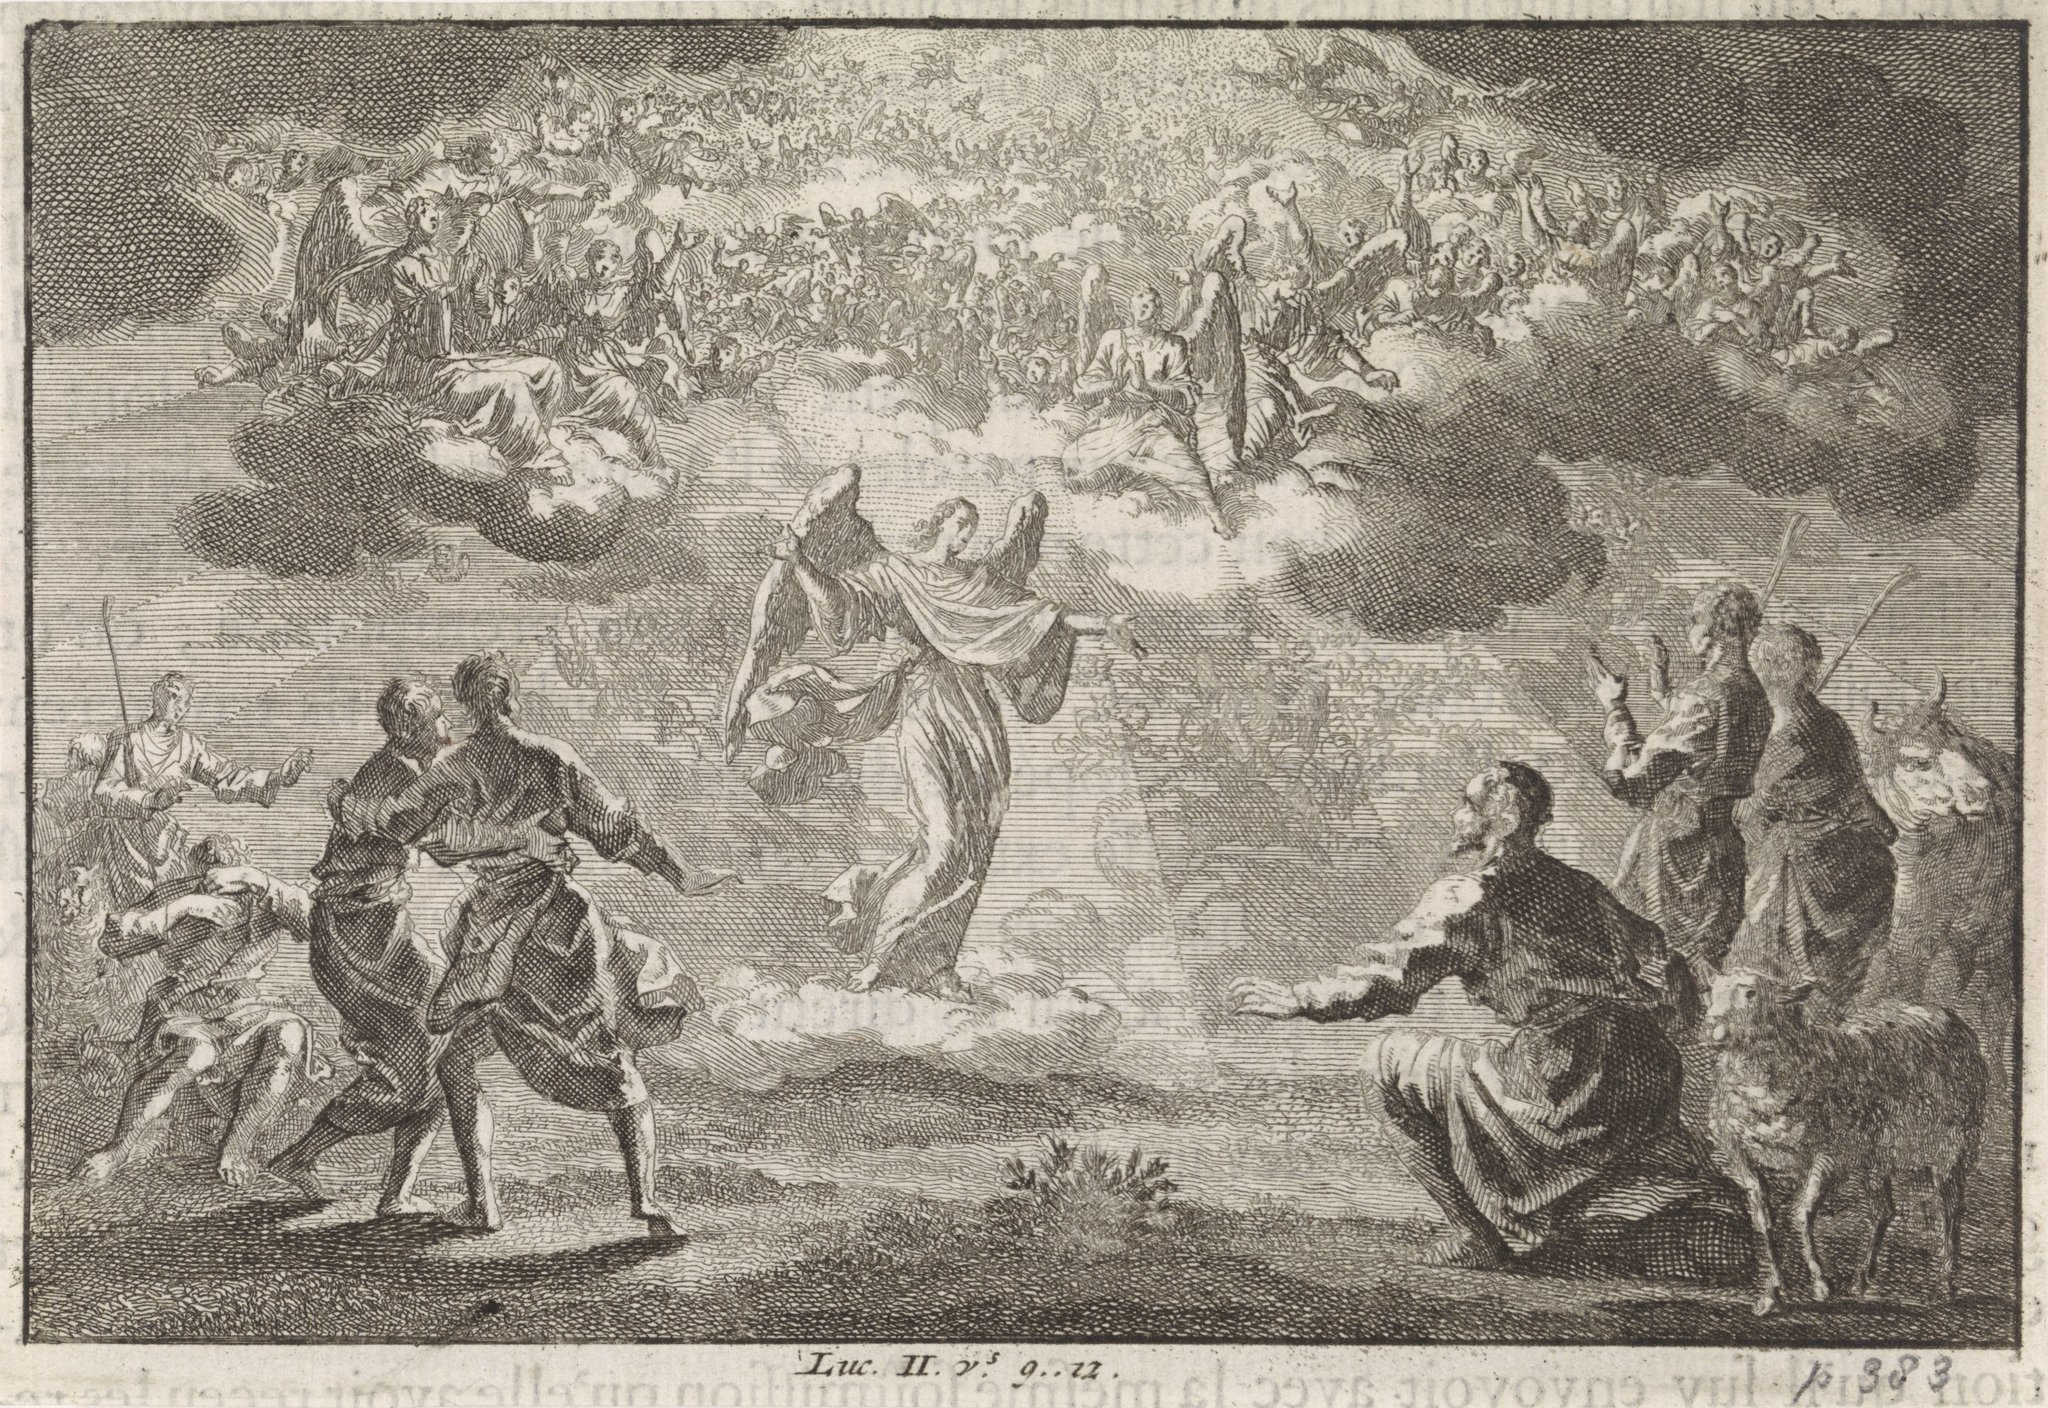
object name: book illustration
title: Verkondiging aan de herders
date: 1703-1762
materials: paper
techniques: etching, letterpress printing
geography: haarlem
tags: annunciation of christ's birth to the shepherds (and/or shepherdesses) at night; a host of singing angels in the air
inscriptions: collector's mark: Lugt 2228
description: De prent komt een eerste keer voor als boekillustratie voor David Martin. Historie des Ouden en Nieuwen Testaments. Amsterdam, Pieter Mortier, 1703. Deel II. De boekillustraties voor de Mortierbijbel hebben verschillende staten en kopieën, waarbij de chronologische volgorde moeilijk te achterhalen valt. Als boekillustraties werden ze bovendien herhaaldelijk opnieuw gebruikt voor andere boekwerken.